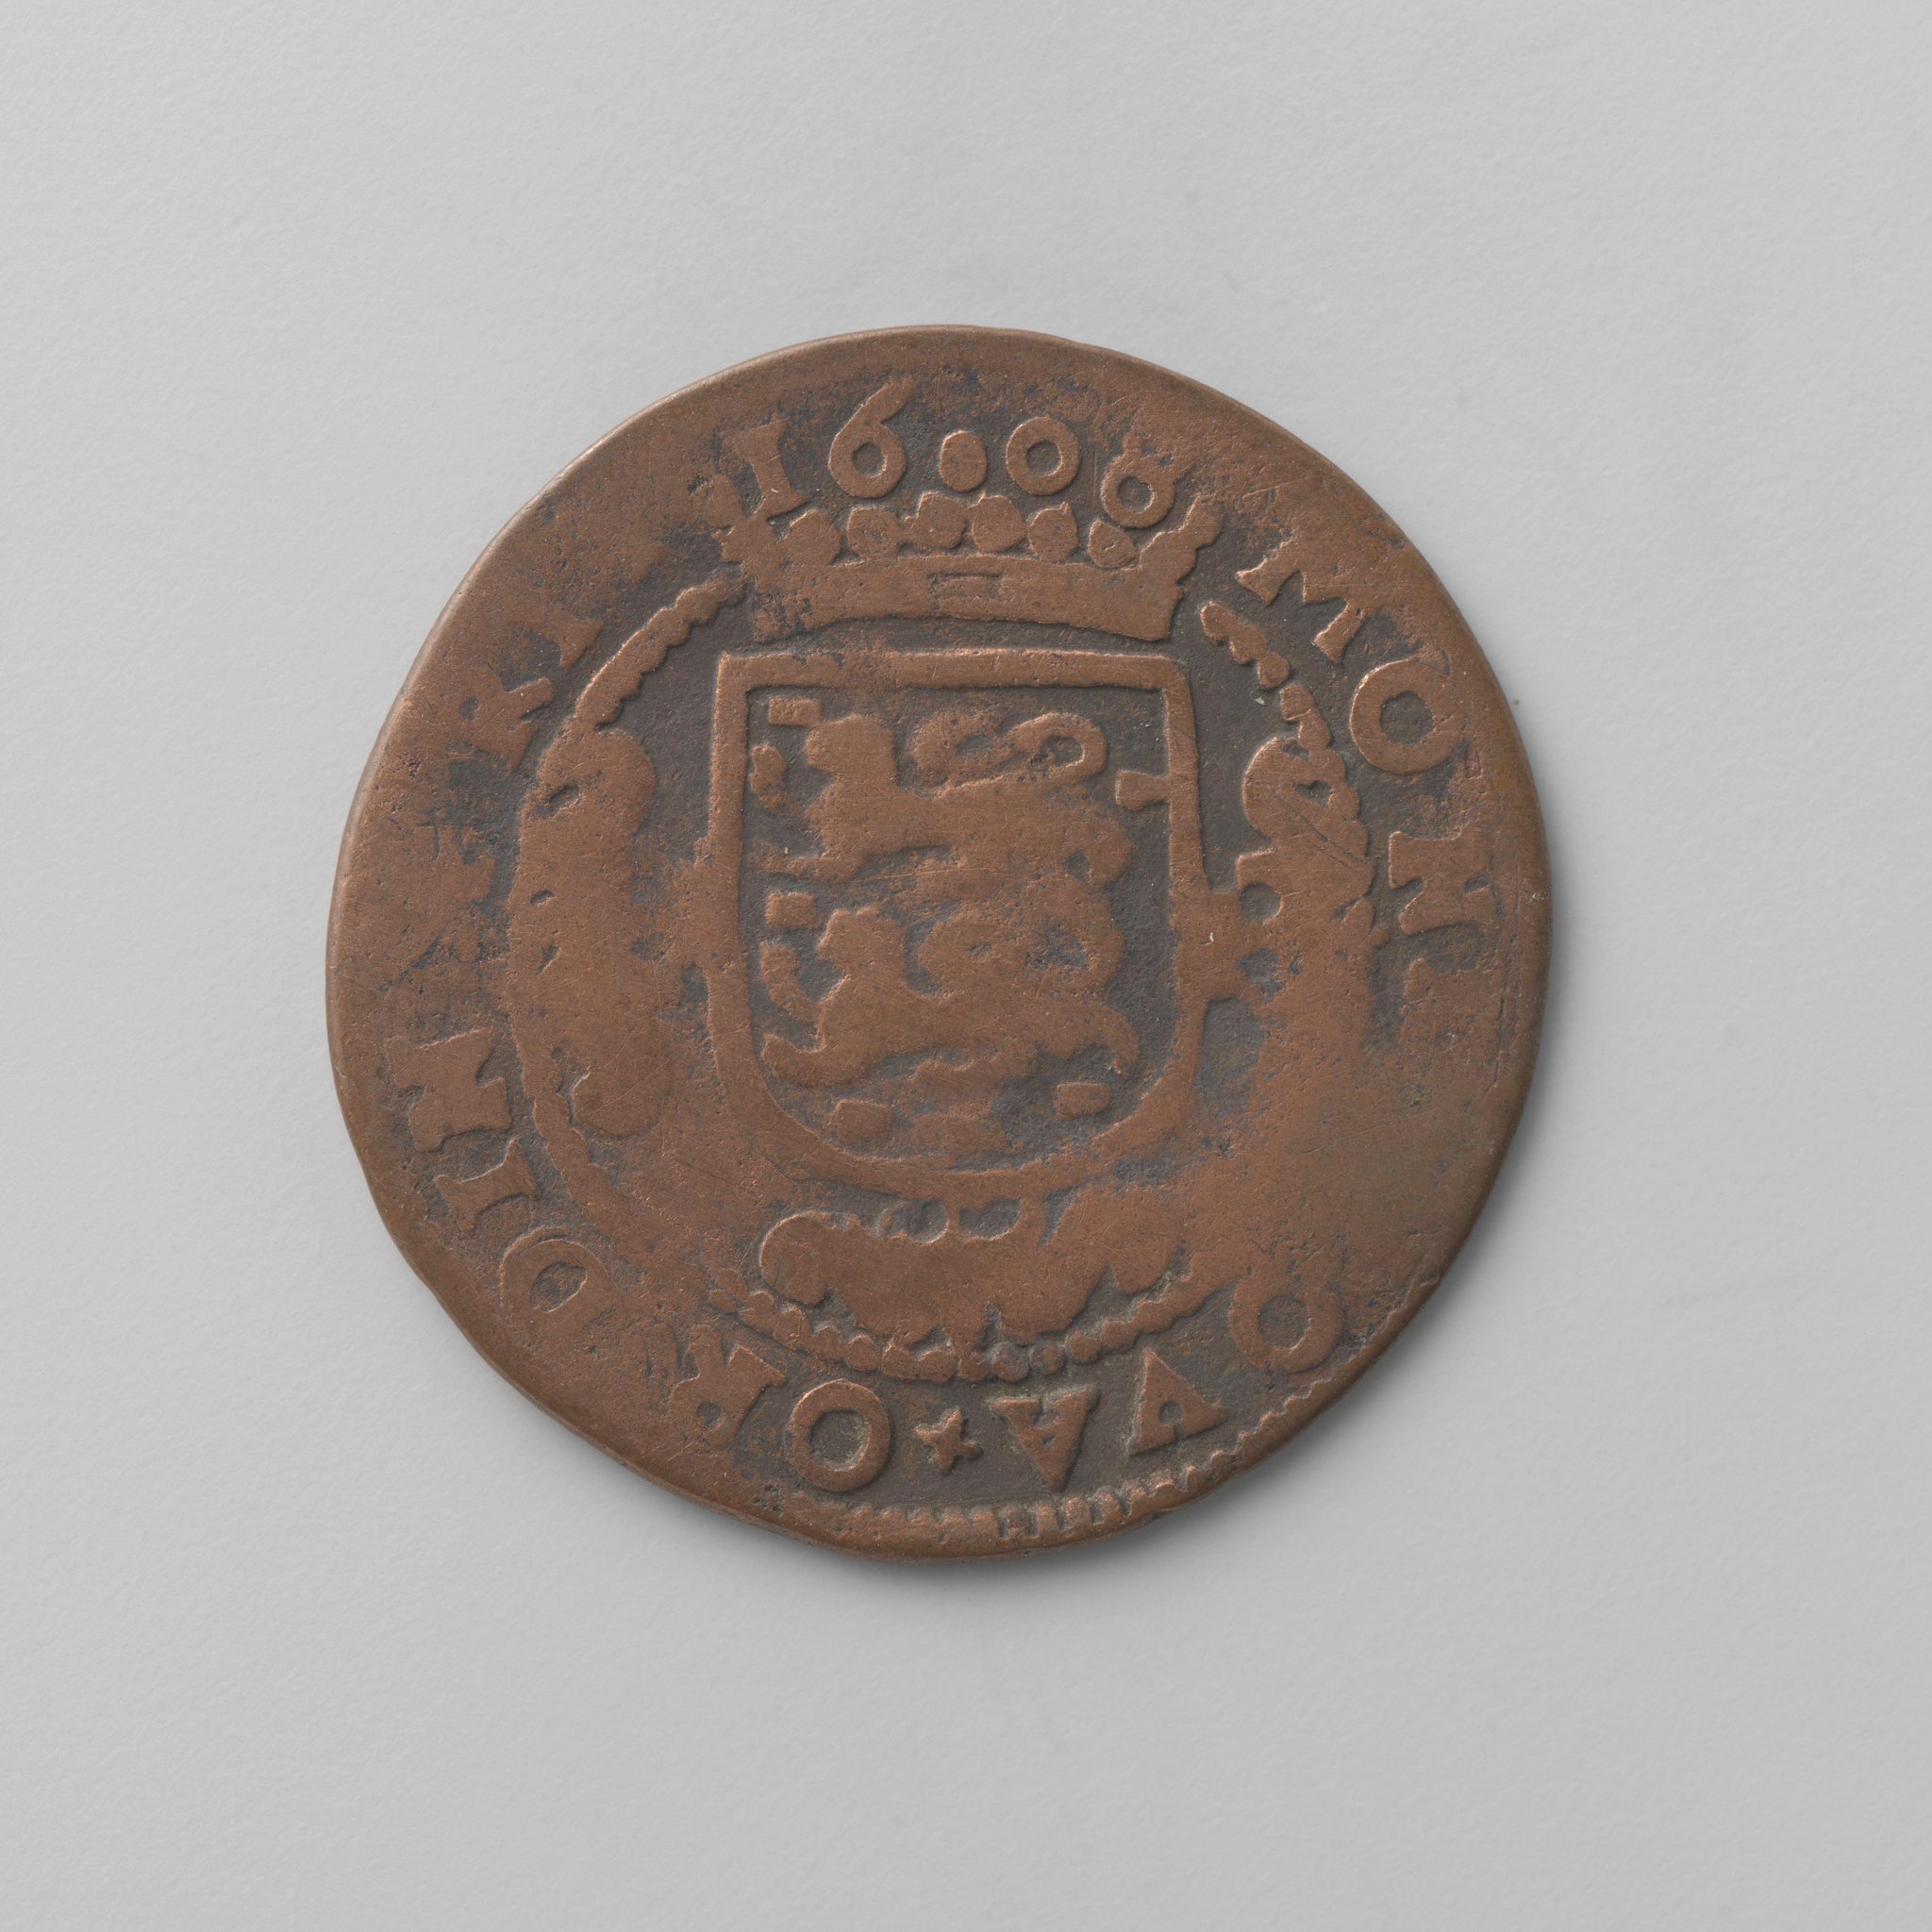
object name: oord, oortje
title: Oord van Friesland, 1608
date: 1608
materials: copper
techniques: striking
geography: leeuwarden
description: Koperen munt. Voorzijde: tussen waarde-aanduiding F O edelman met muts naar rechts. In rechterhand zwaard. Keerzijde: op kort gebloemd kruis gekroond wapenschild van Friesland. Jaartal boven kroon in omschrift.